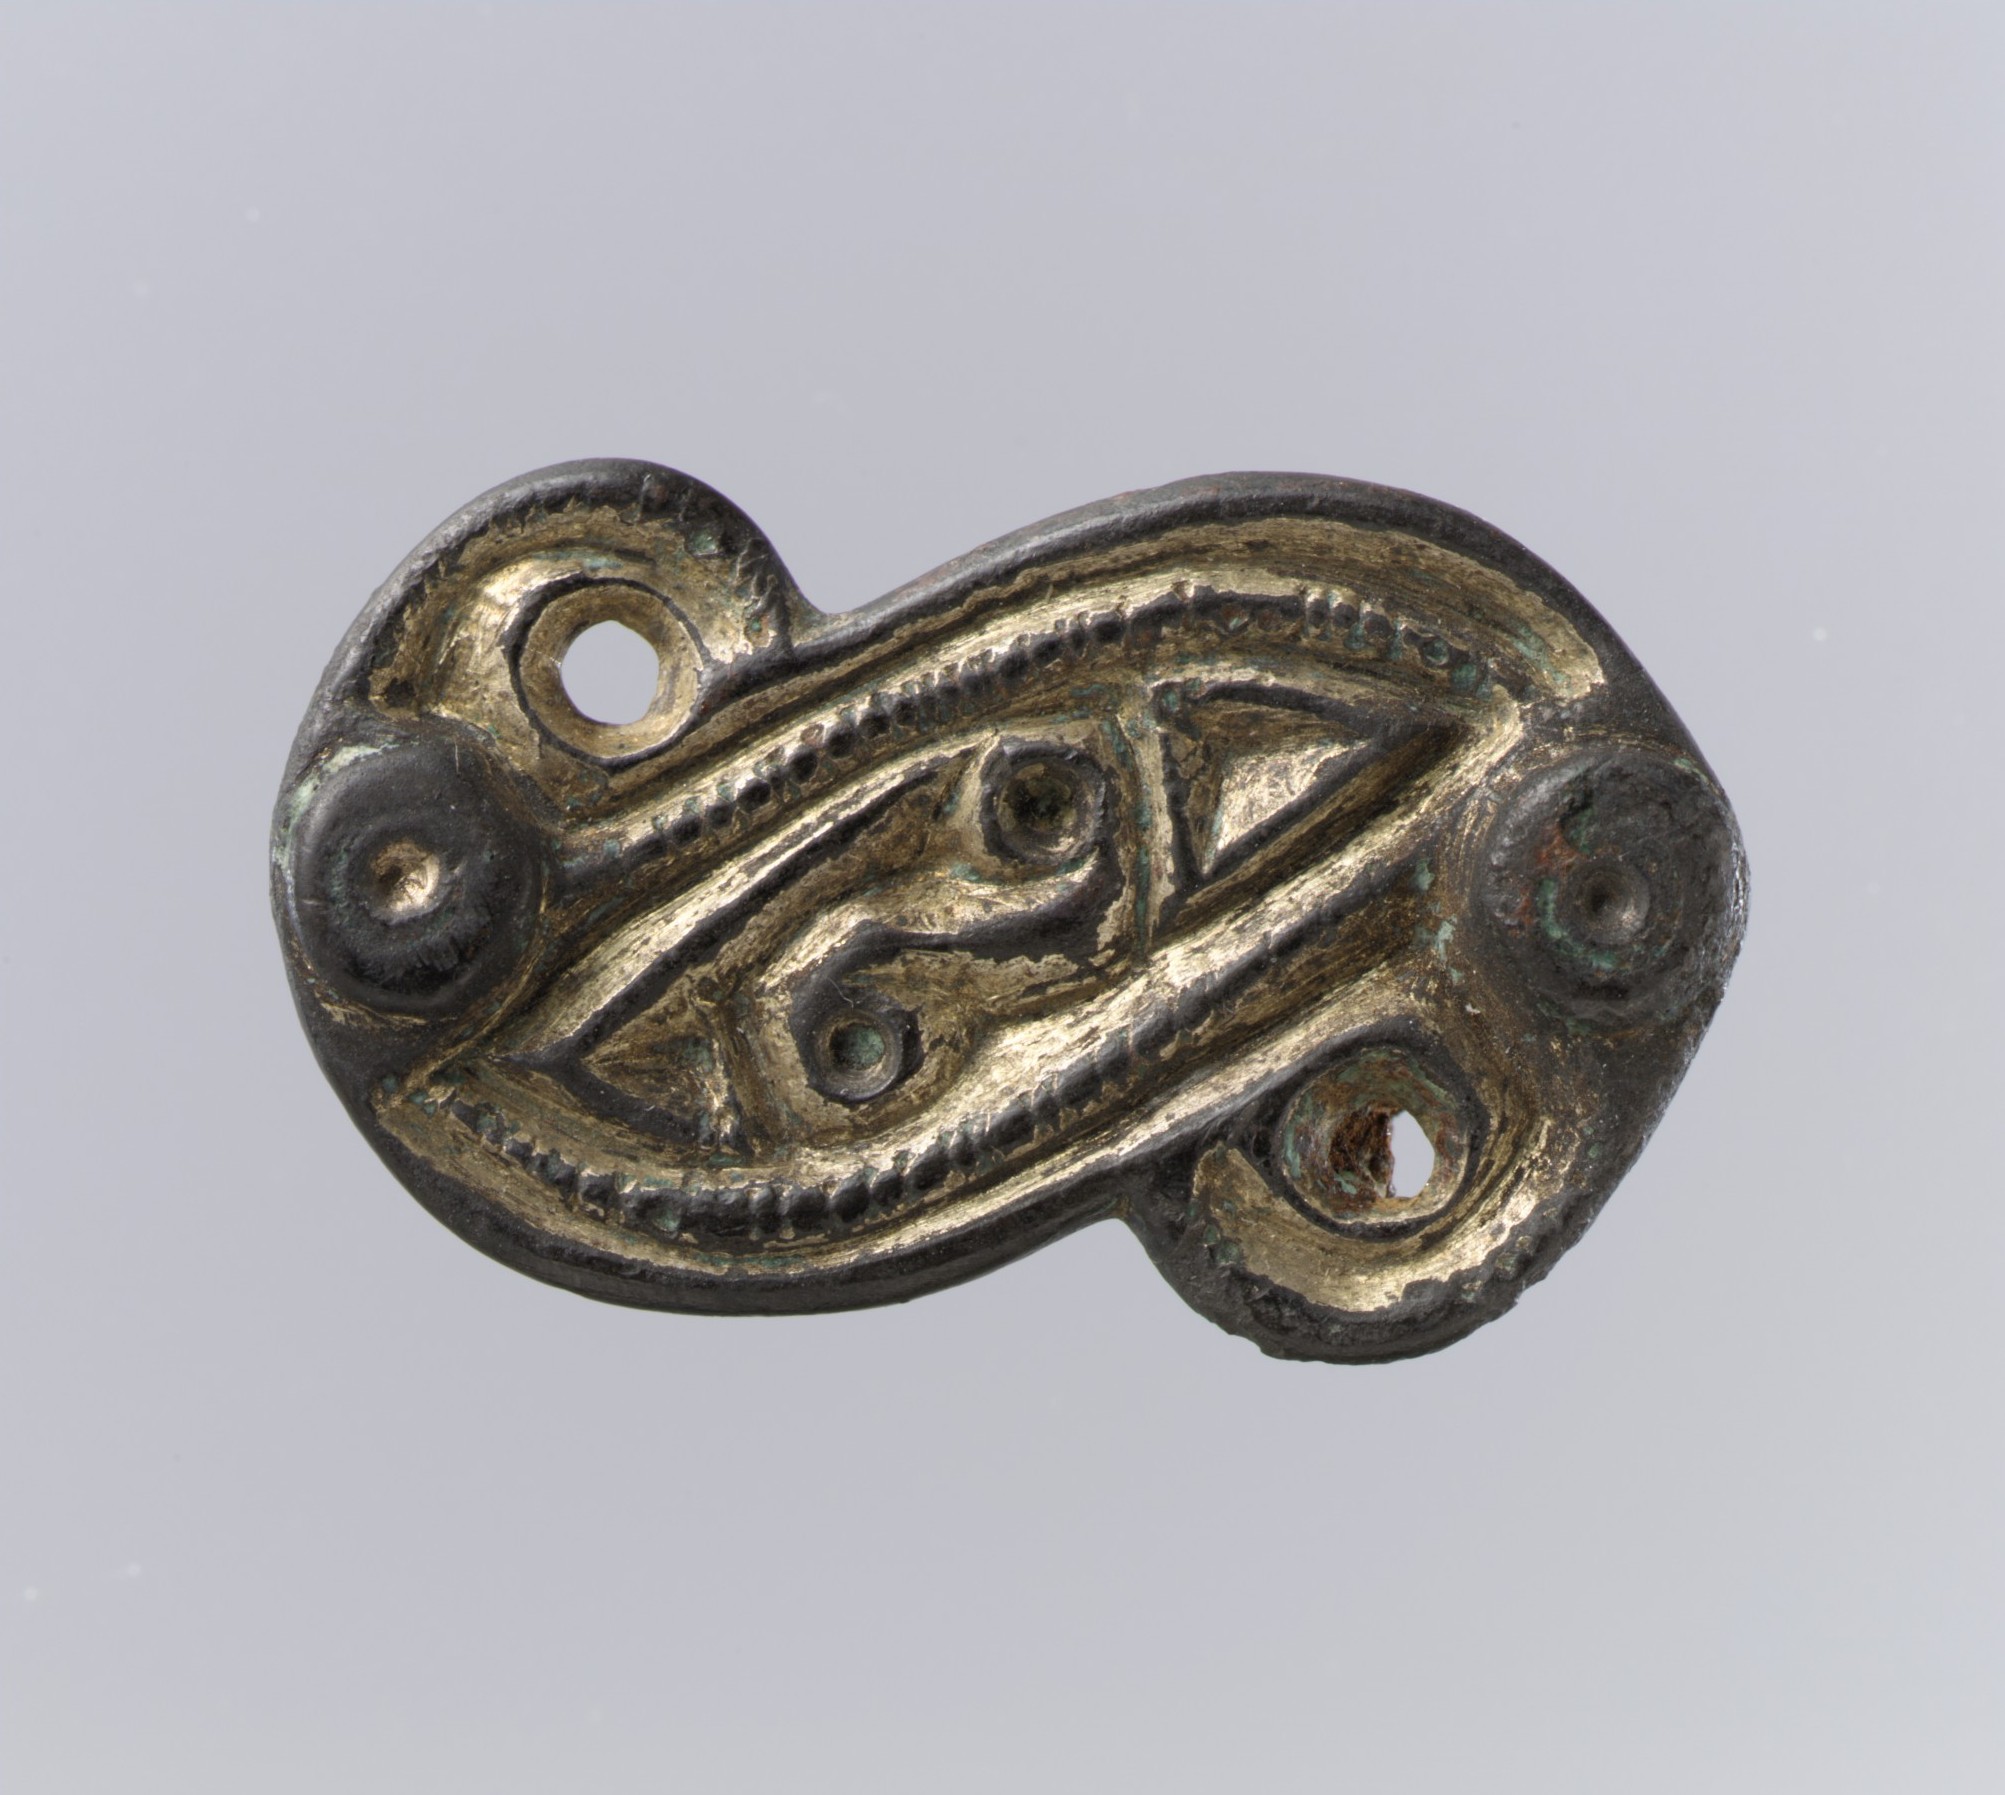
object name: brooch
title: S-Shaped Brooch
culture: frankish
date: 501-550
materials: silver gilt